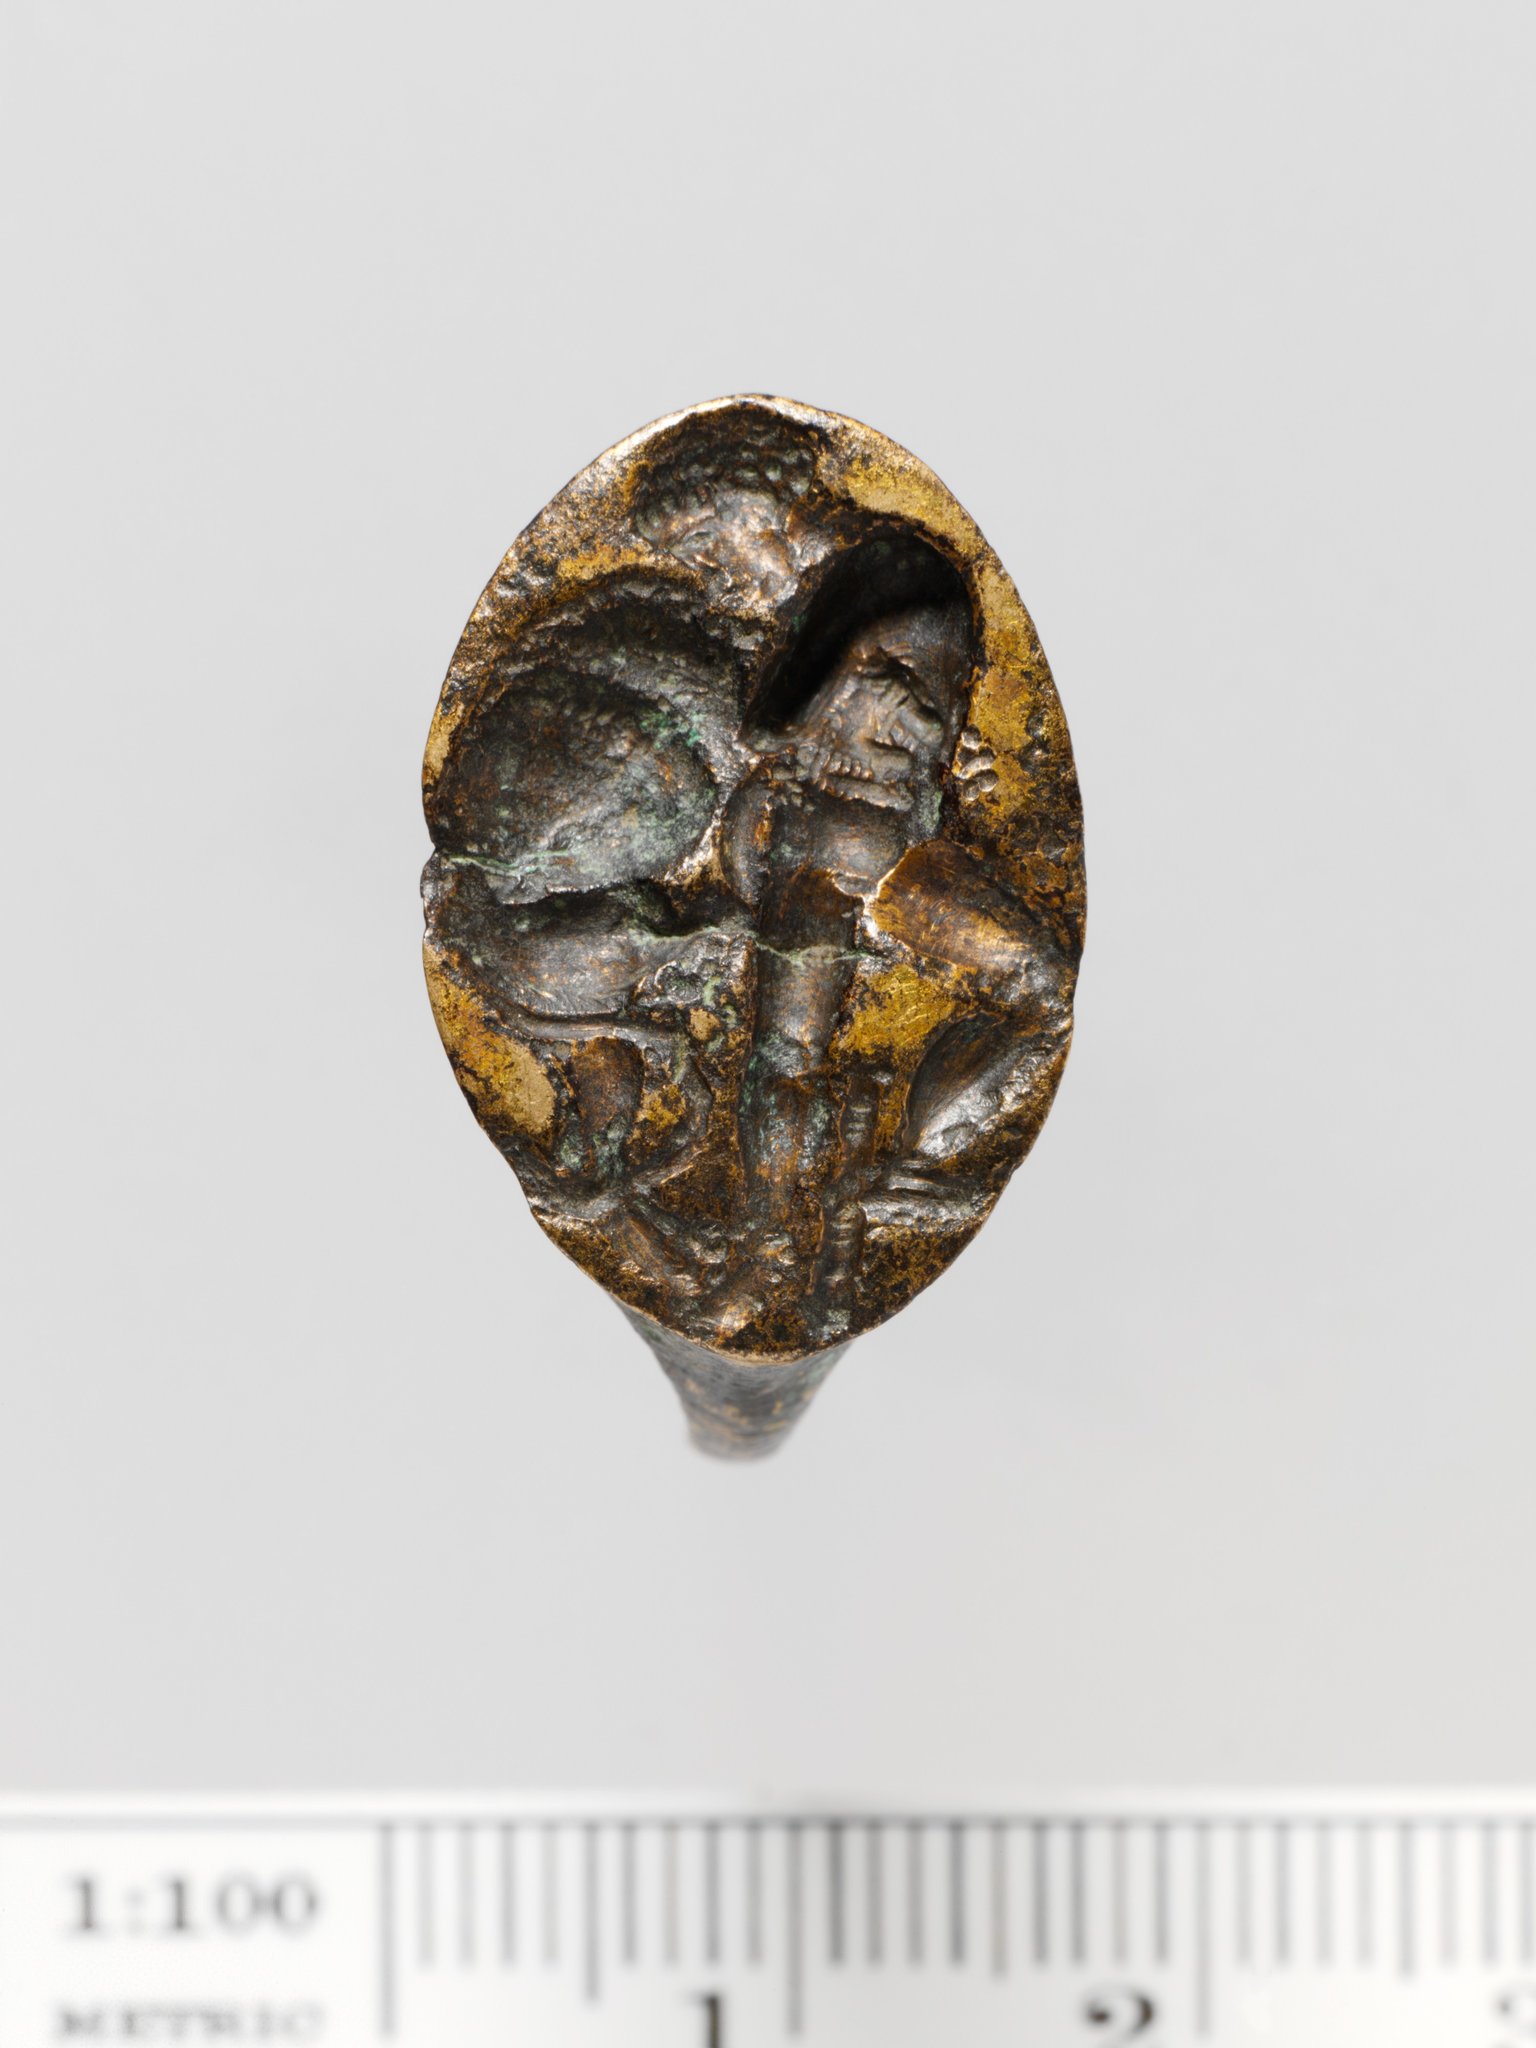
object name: ring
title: Gilt bronze ring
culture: greek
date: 400-368 BCE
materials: bronze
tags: herakles